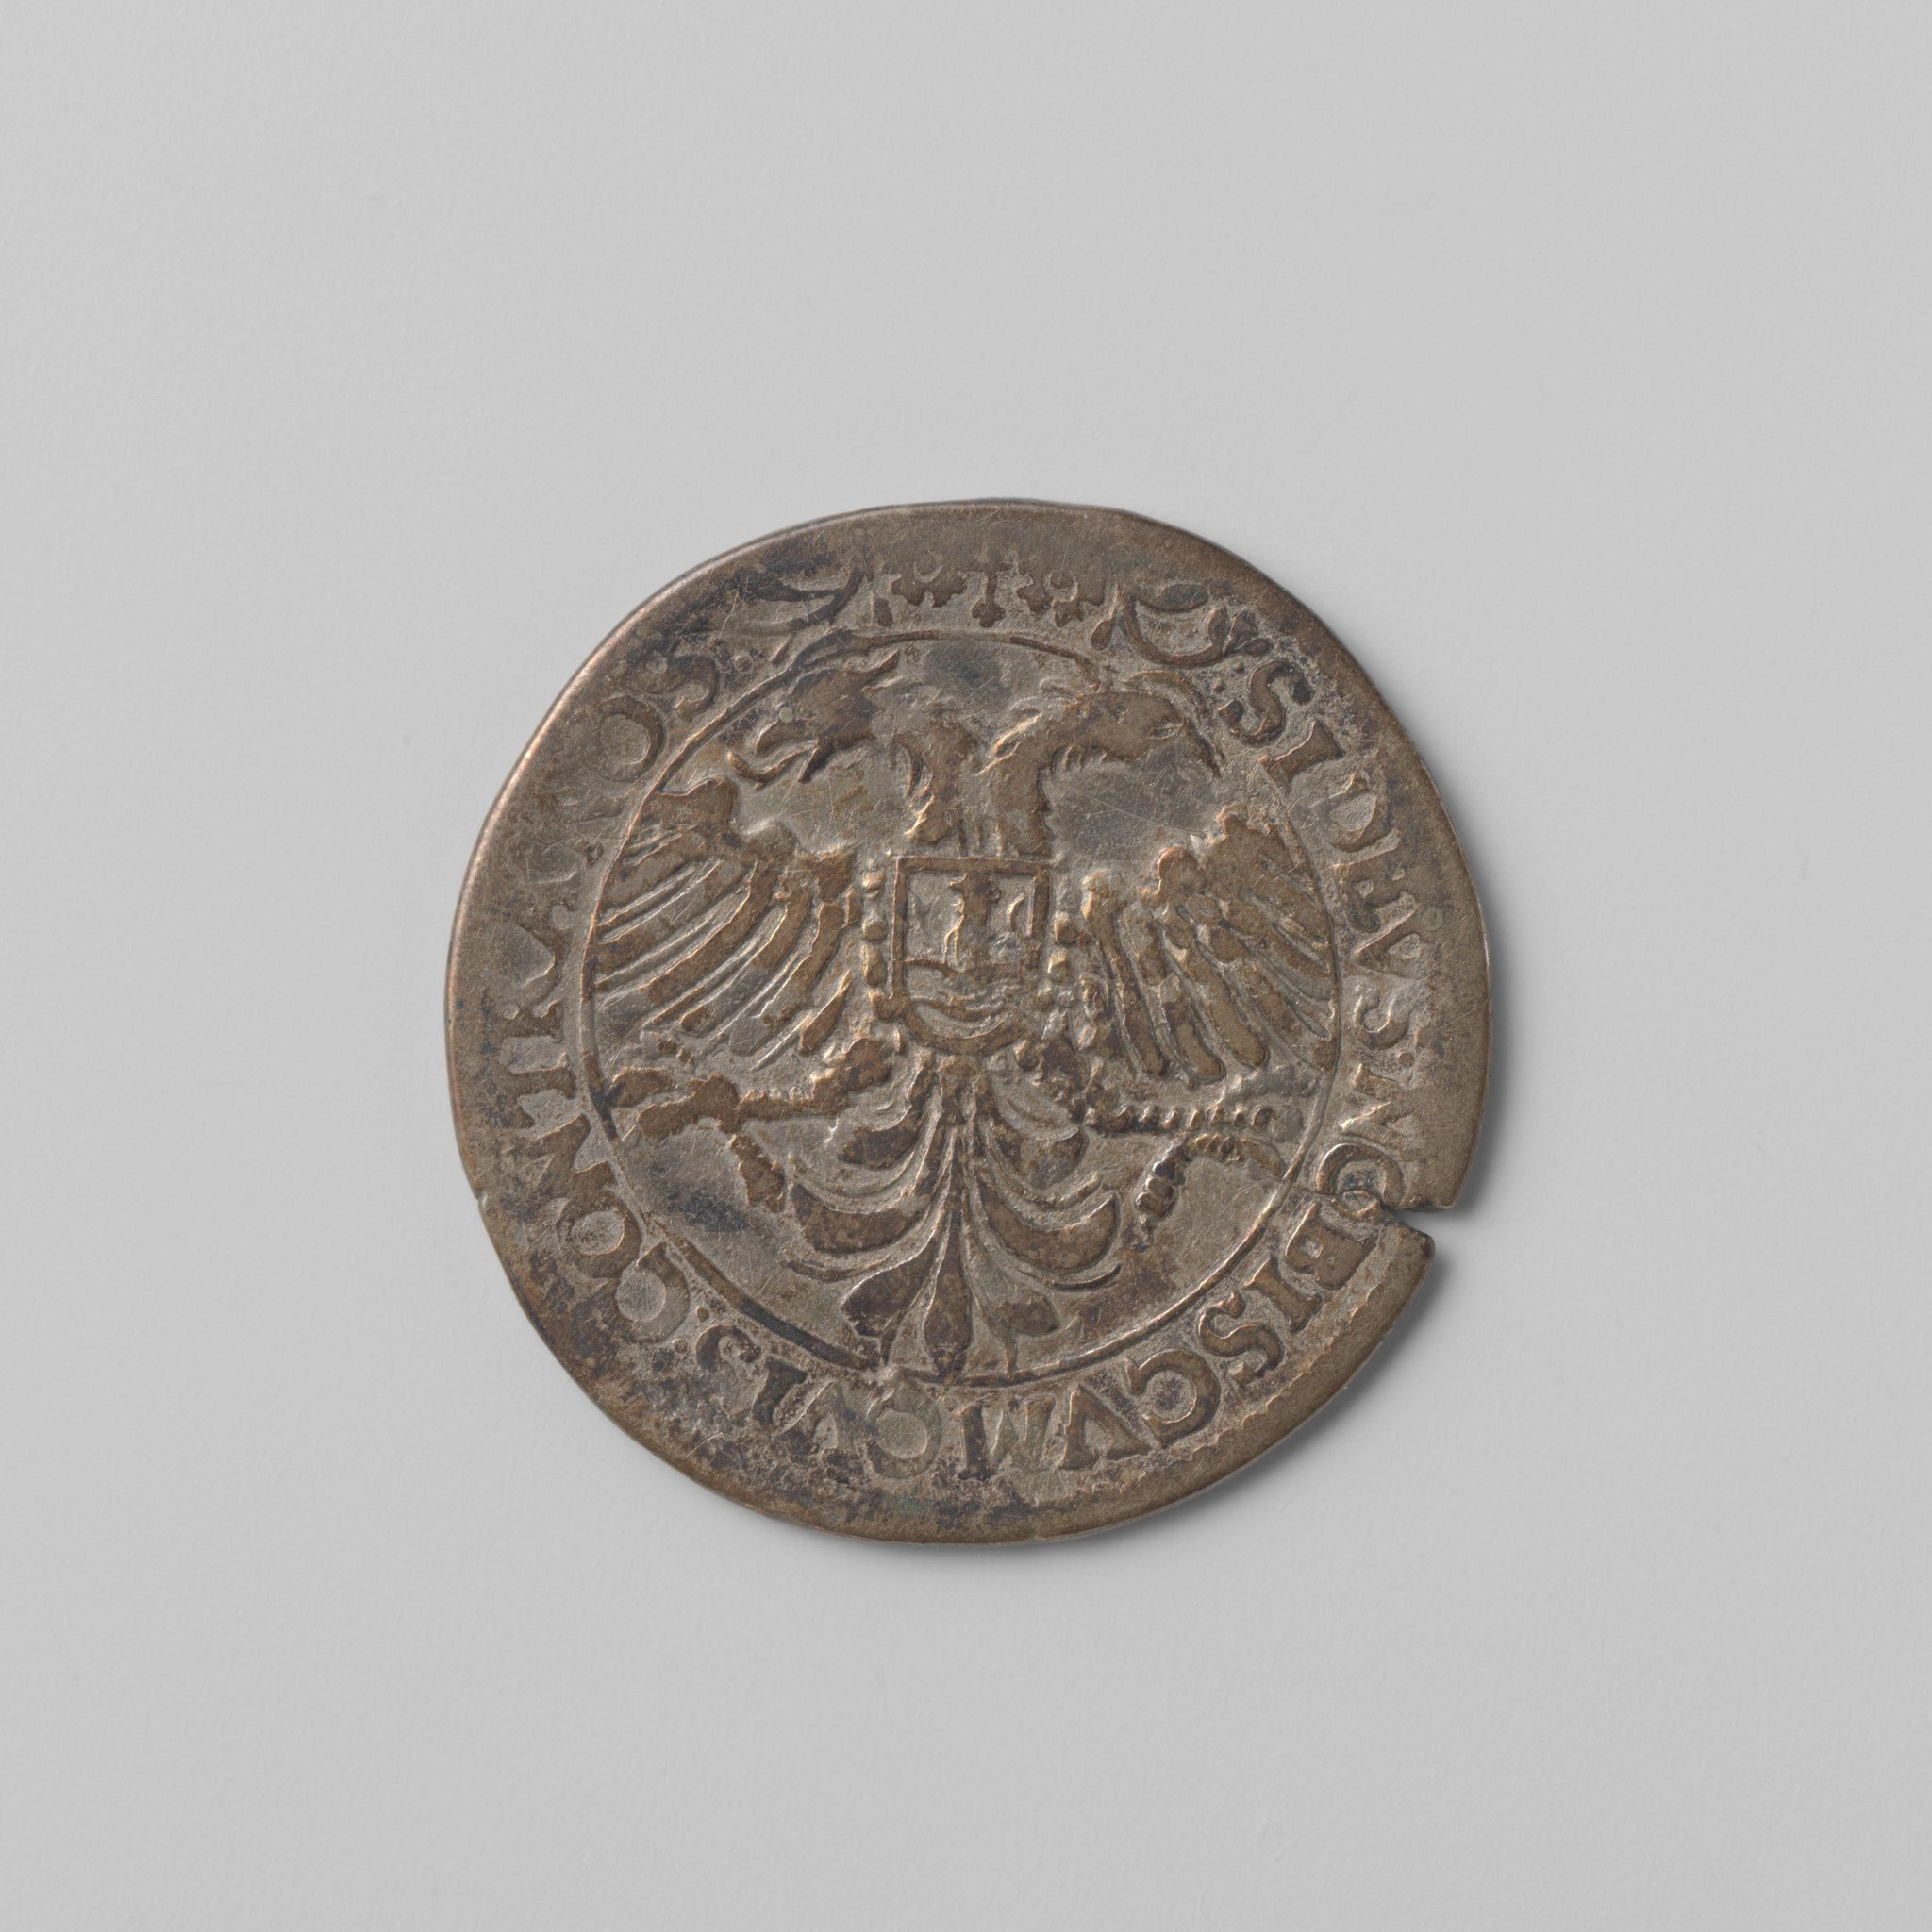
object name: coin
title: Zeeuwse derde daalder van 20 groot, 1602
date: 1602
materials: silver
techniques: striking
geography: middelburg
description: Zilveren munt. Voorzijde: dubbelkoppige adelaar met op borst wapenschildje van Zeeland. Keerzijde: versierd wapenschild met wapens van Zeeuwse steden en de eerste edele, onder wapenschild waarde-aanduiding 20.